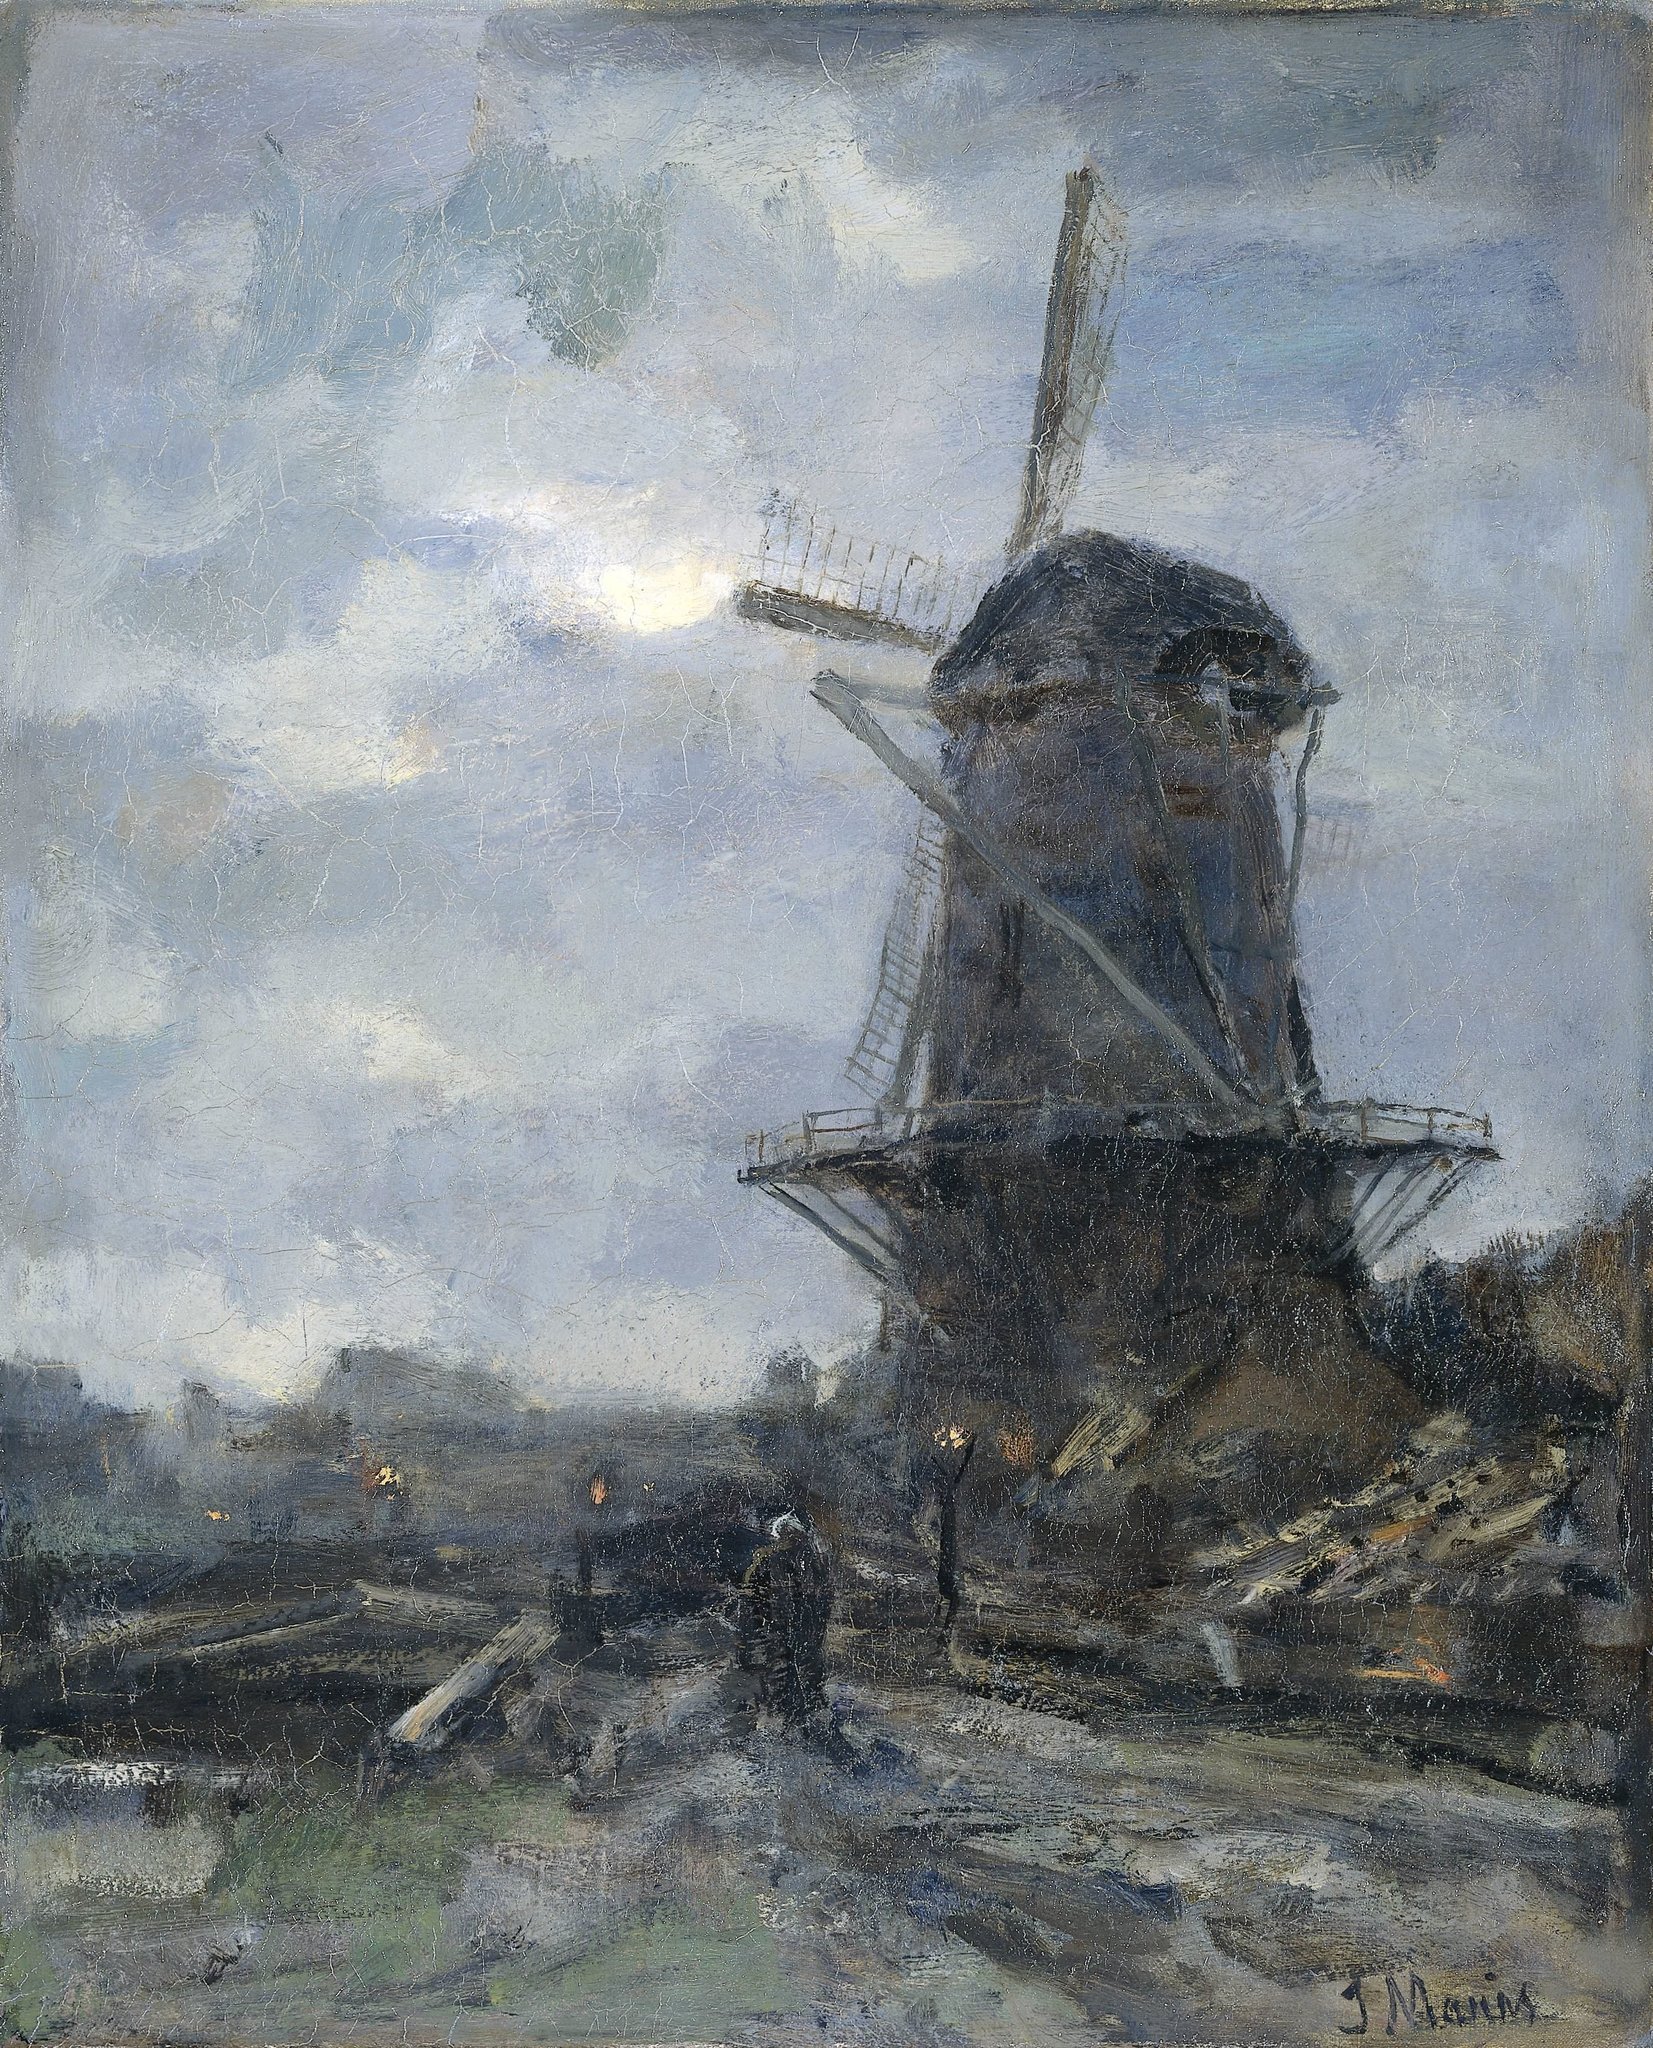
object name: painting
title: Molen bij maanlicht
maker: jacob maris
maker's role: draughtsman, painter, print maker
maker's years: 1837-1899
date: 1899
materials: canvas, oil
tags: moonlight, windmill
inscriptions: signature: ‘J Maris’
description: Een windmolen bij maanlicht. Op de voorgrond een zandweg met een figuur, in de verte huizen en lantaarns.